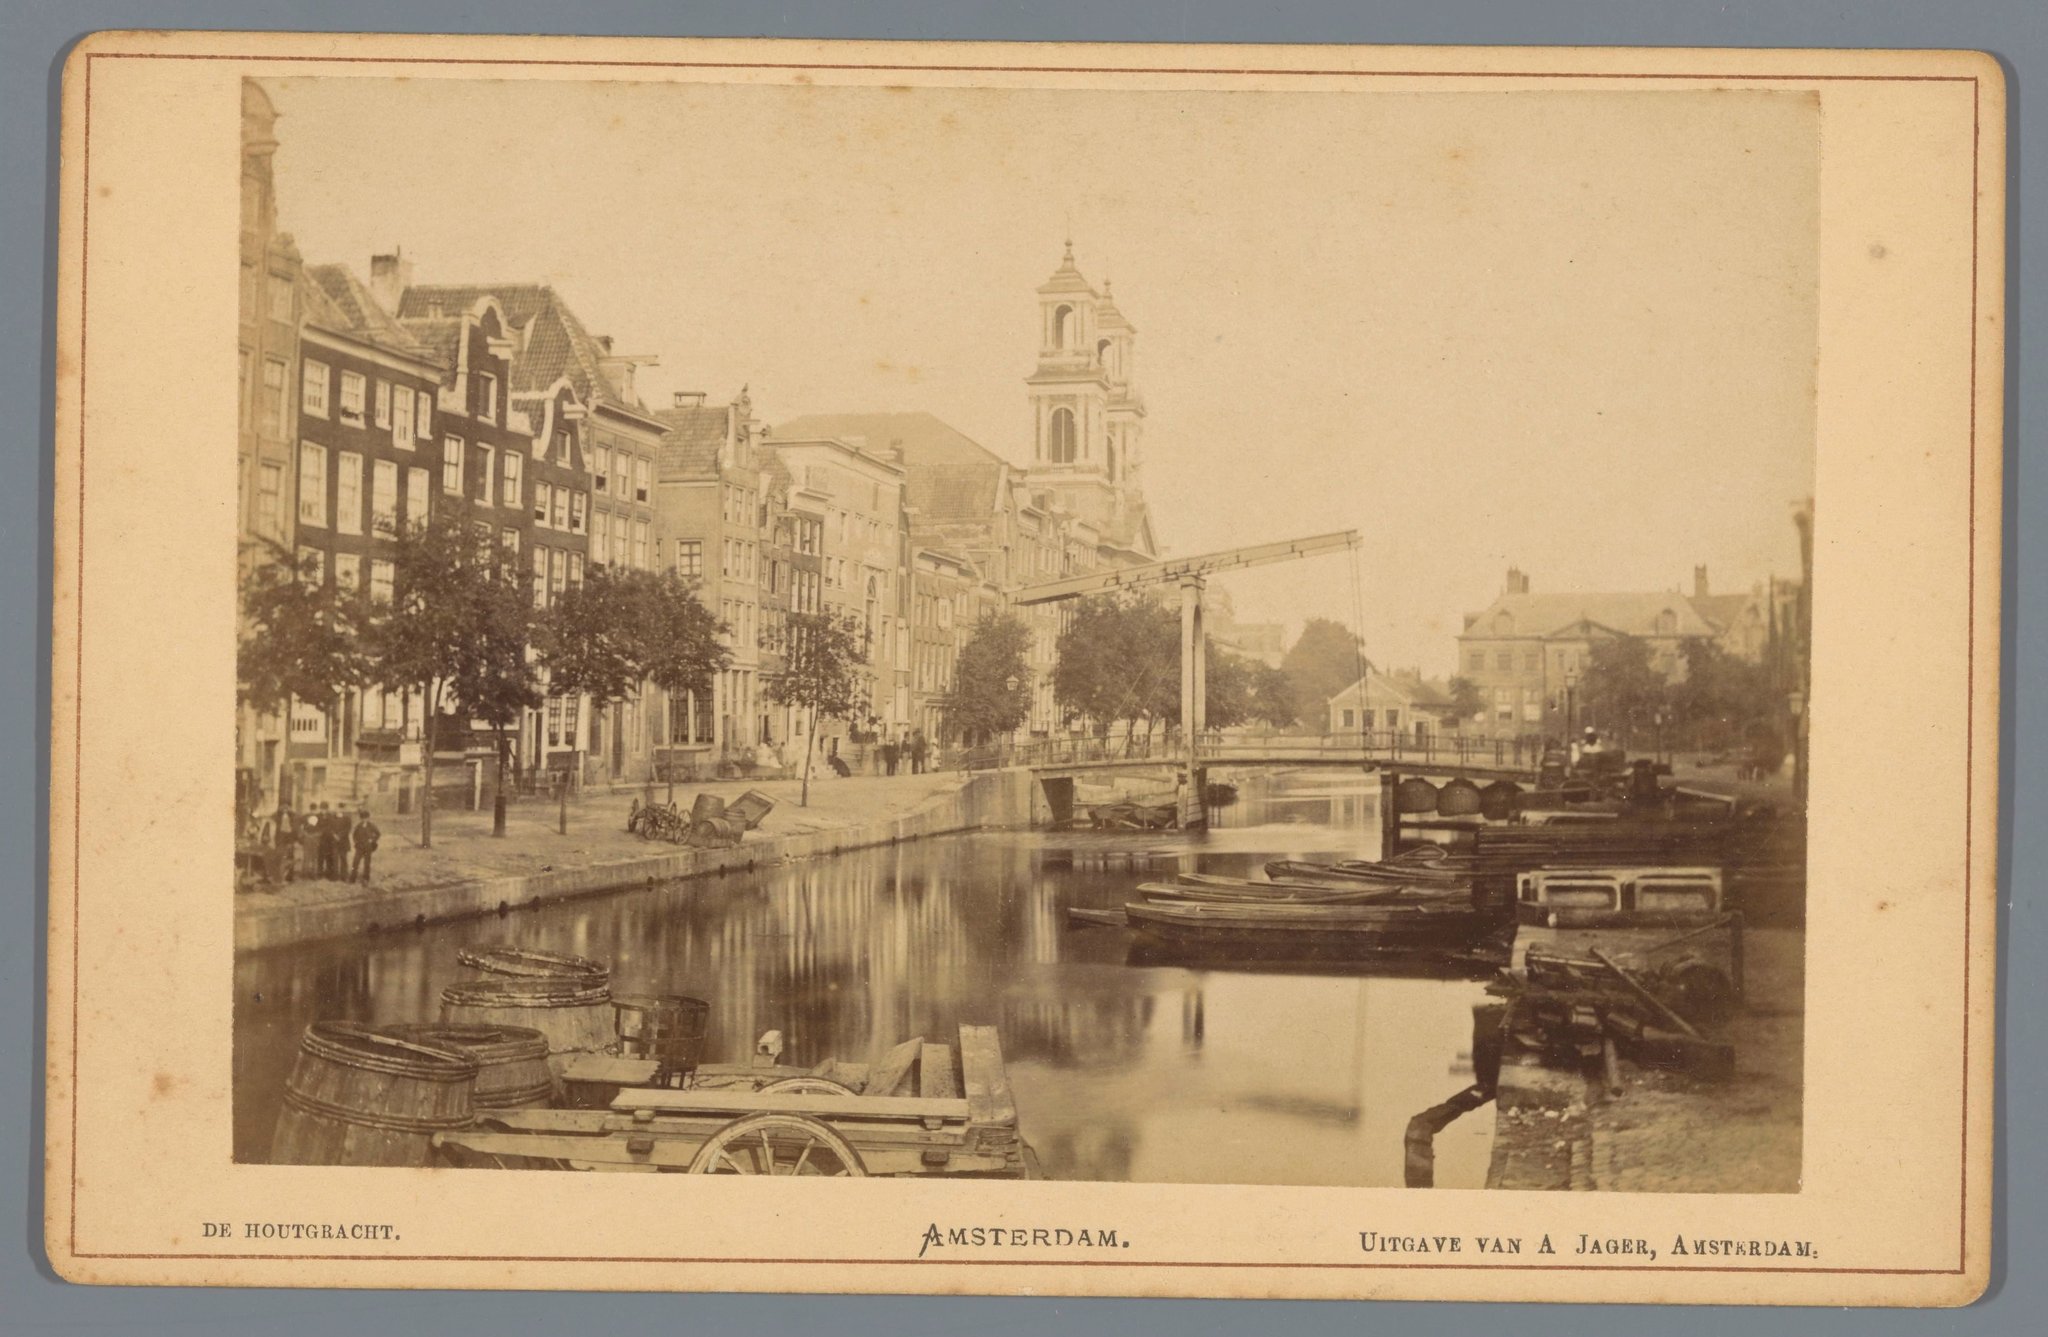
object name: cabinet photograph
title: Gezicht op de Houtgracht in Amsterdam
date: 1860-1883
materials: cardboard, photographic support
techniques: albumen print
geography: amsterdam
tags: canals, waters (in city)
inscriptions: annotation: ‘Voormalige houtgracht-gedempt/ in 1883’